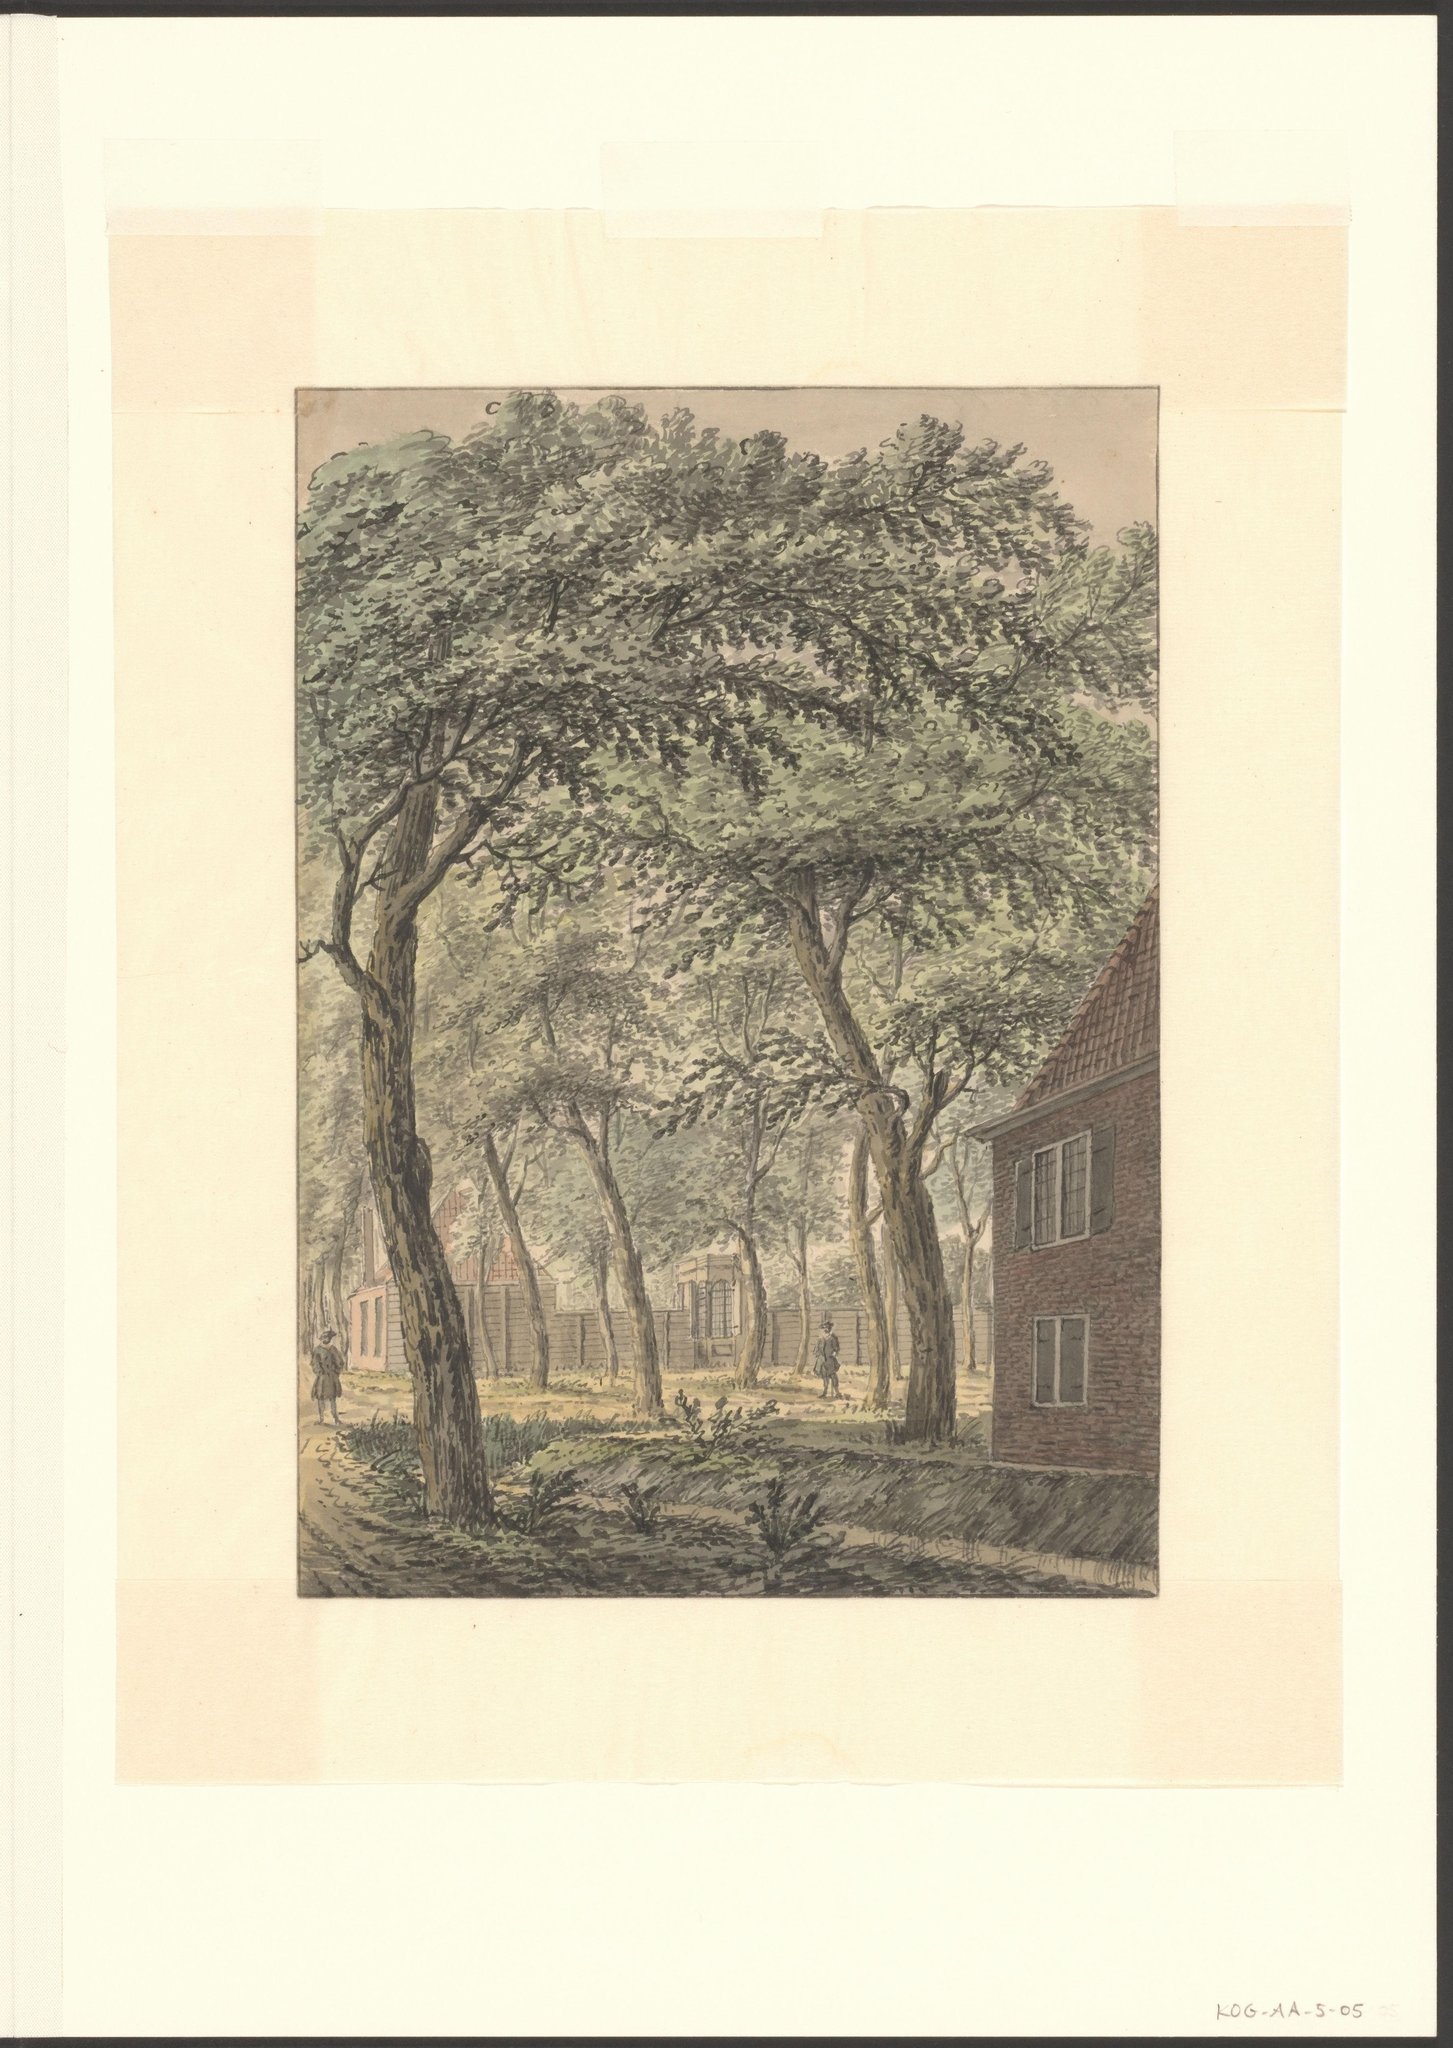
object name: drawing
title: Gezicht op de Plantagebuurt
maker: jacobus kops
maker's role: draughtsman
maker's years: 1736-1773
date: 1746-1773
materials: paper, pencil, watercolor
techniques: brush, pen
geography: amsterdam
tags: city-view in general; 'veduta', public gardens, park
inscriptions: number: ‘8’